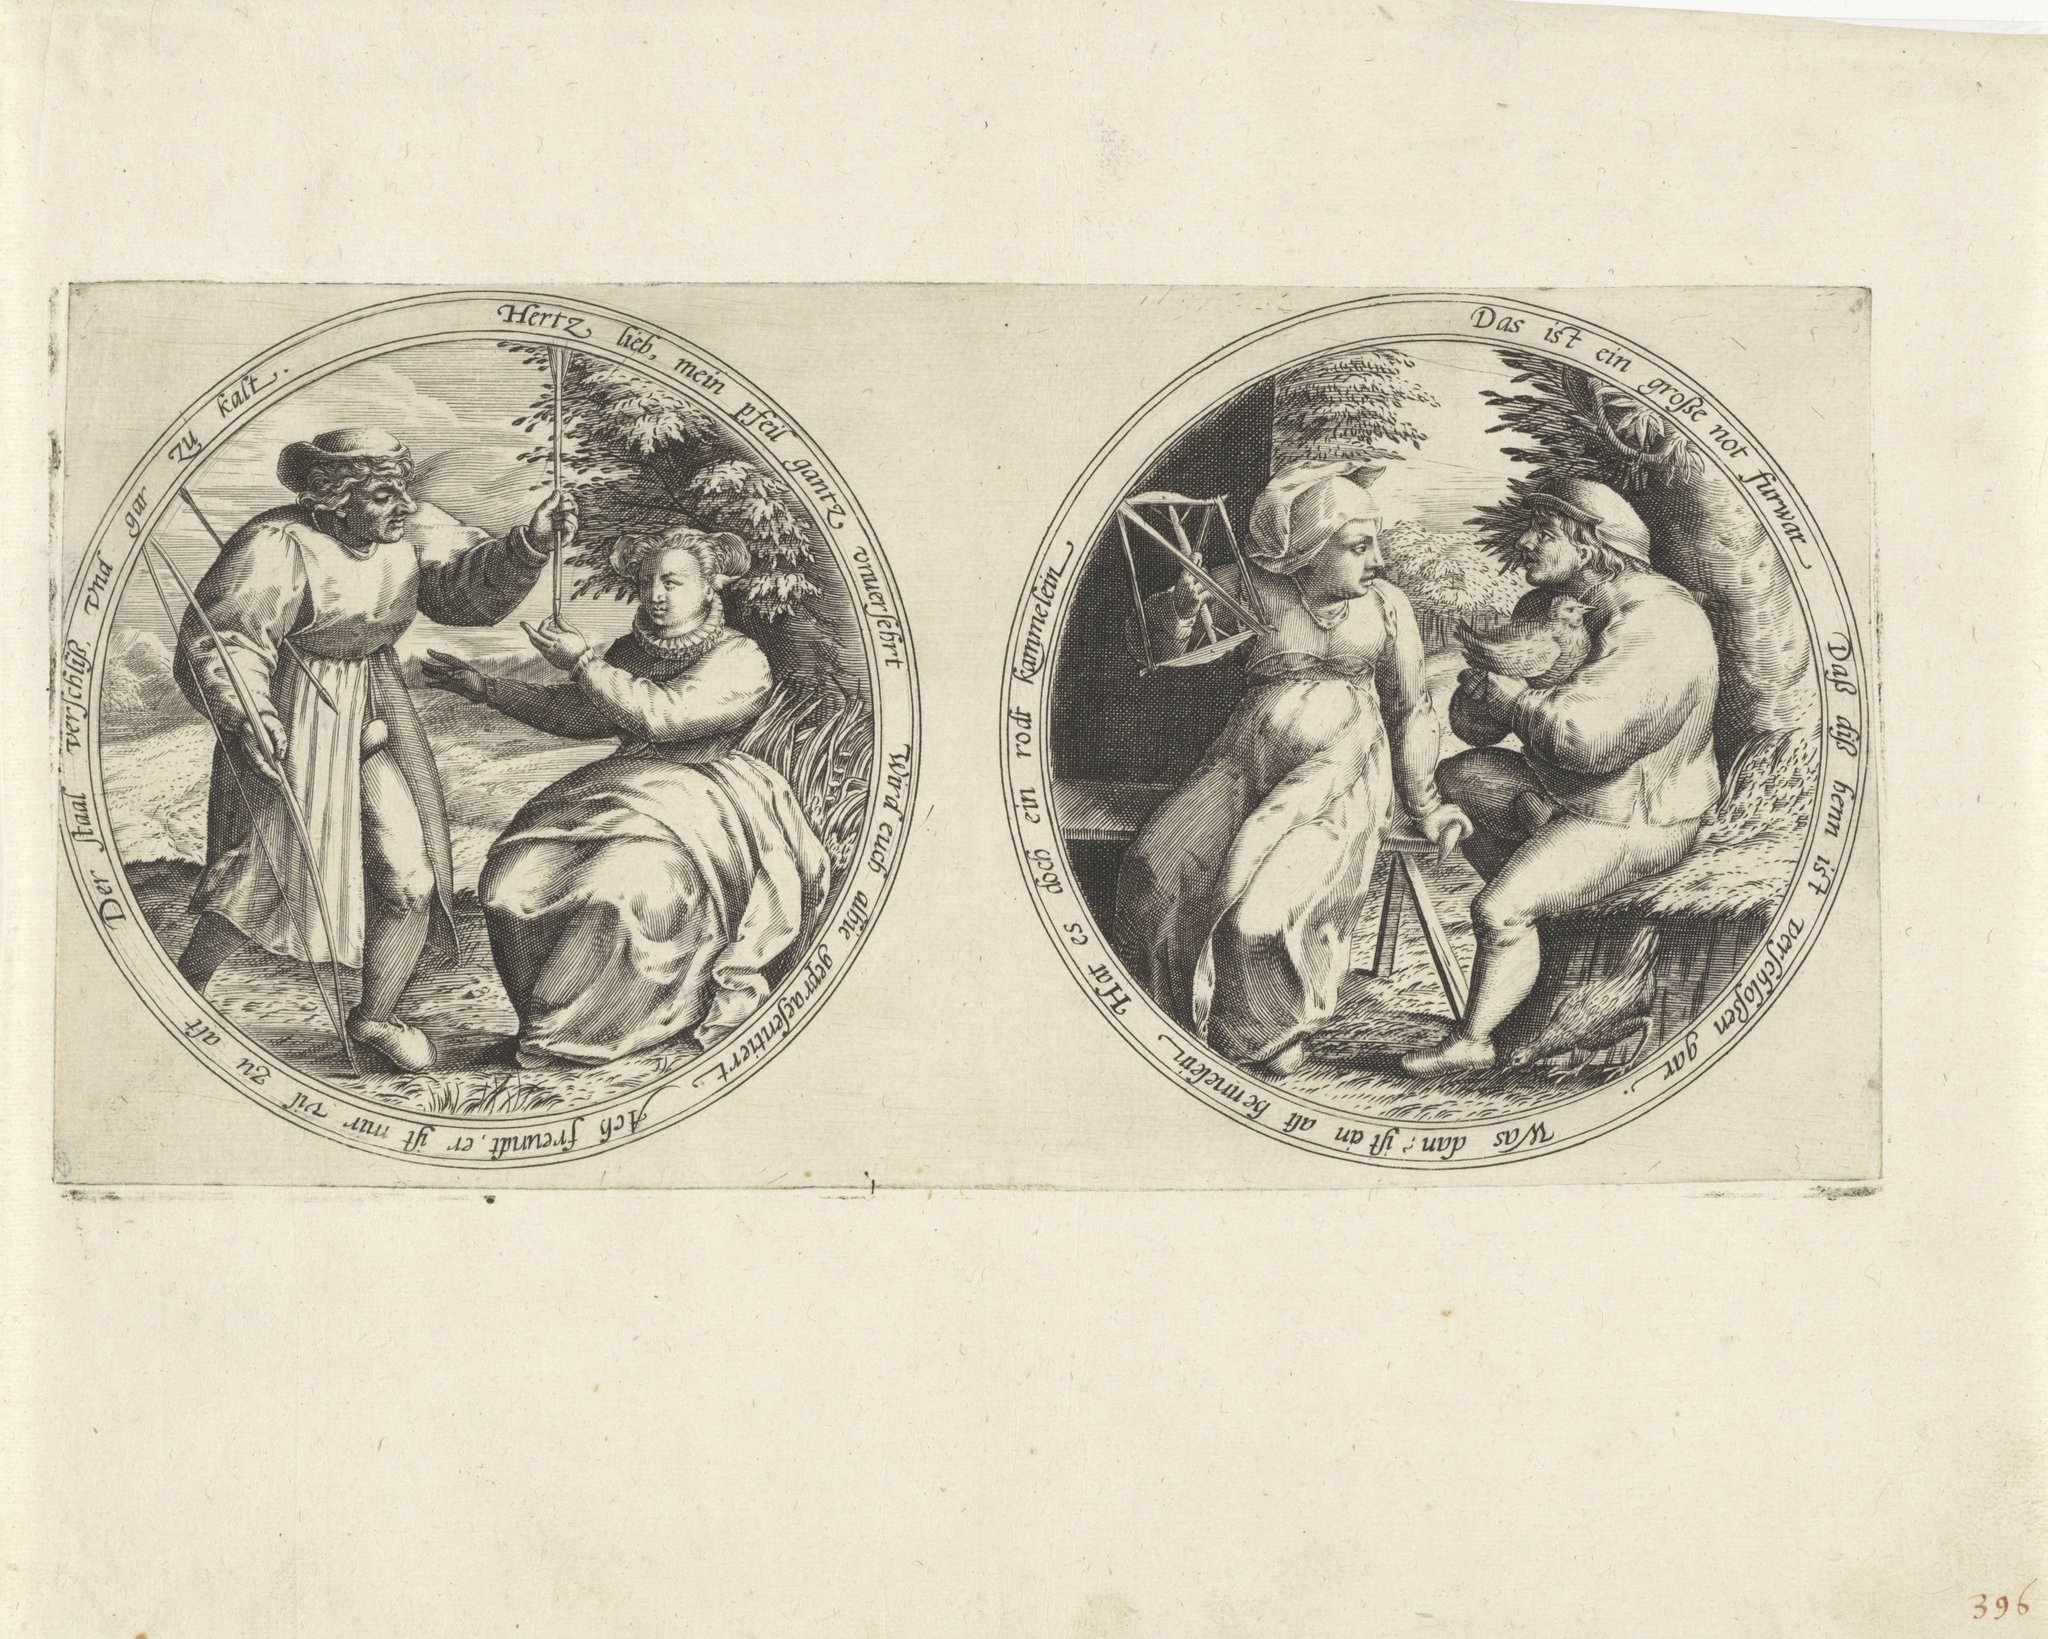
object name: print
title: Boogschutter en een boer met pluimvee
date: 1555-1631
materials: paper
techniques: engraving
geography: southern netherlands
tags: adolescent, young woman, maiden, image of phallus, 'phallos', archer's weapons: arrow, farmers, archer's weapons: bow, fowl (cock, hen, chicken, etc.), sensuality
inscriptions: collector's mark: Lugt 4099, collector's mark: Lugt 2760, number: ‘396’, collector's mark: Lugt 2228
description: Twee medaillons met een dubbelzinnig randschrift in het Duits. Op het linker medaillon laat een boogschutter een jonge vrouw de punt van een pijl voelen. Ze maakt een afkeurend gebaar. Op het rechter medaillon zit een boer met pluimvee bij een jonge vrouw in een schuur. De vrouw toont hem een haspel.